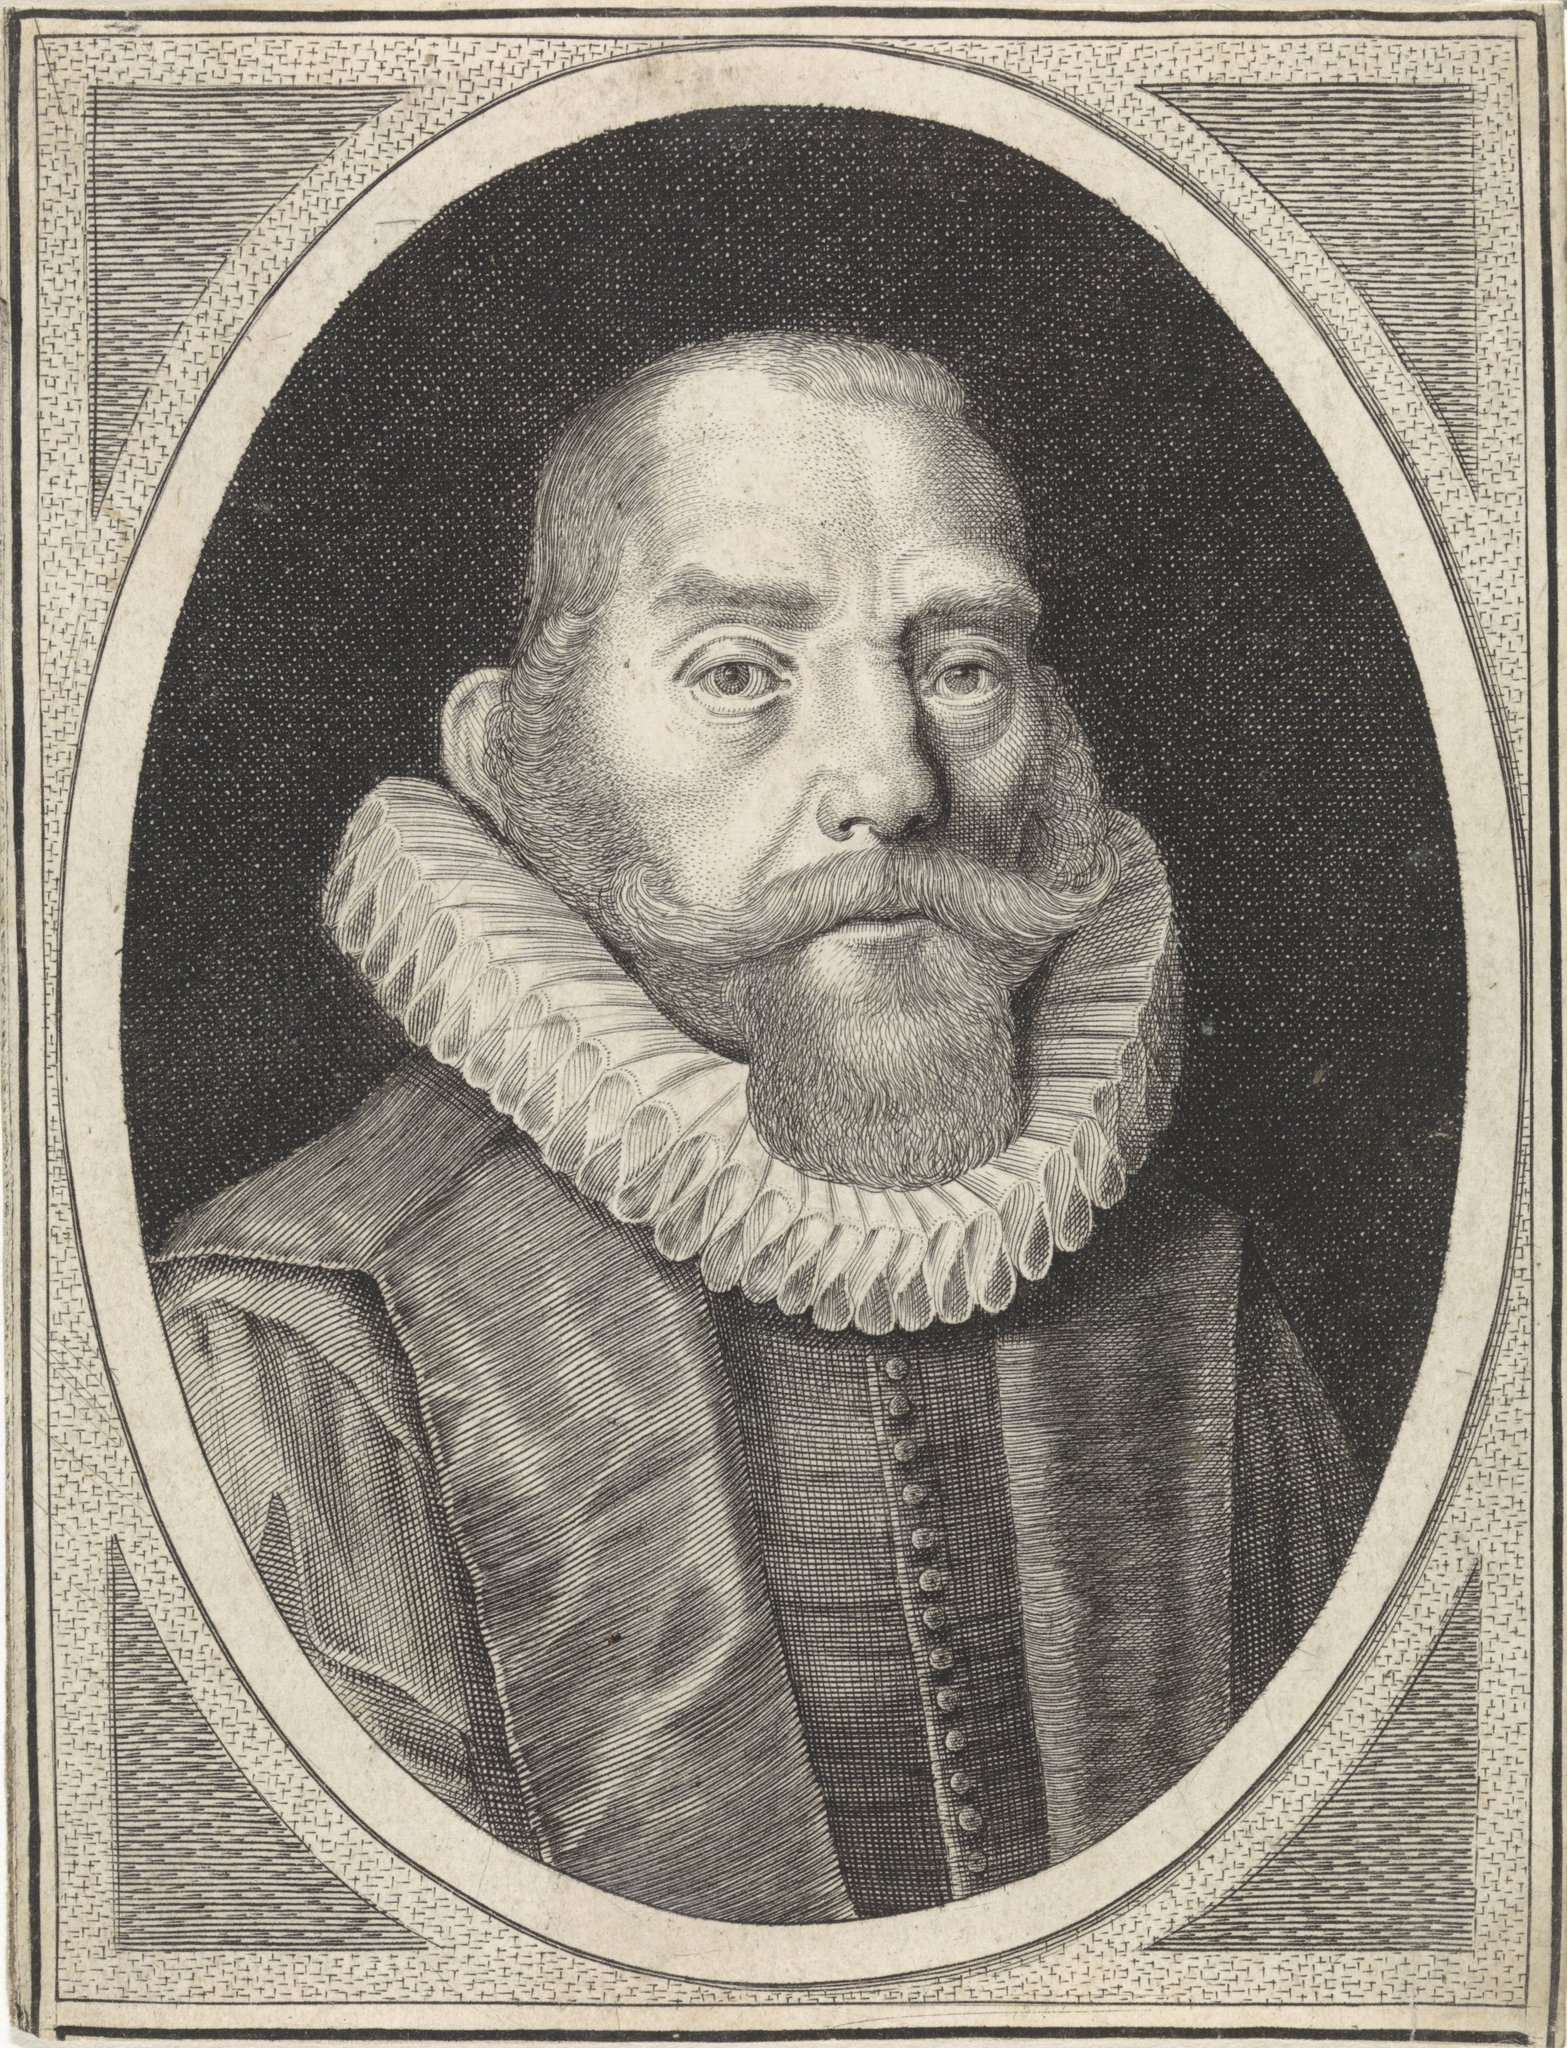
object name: print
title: Portret van Pieter Paauw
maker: de passe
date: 1625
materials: paper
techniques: engraving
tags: amsterdam, leiden, pieter paaw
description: Portret van Pieter Paauw, professor te Leiden.